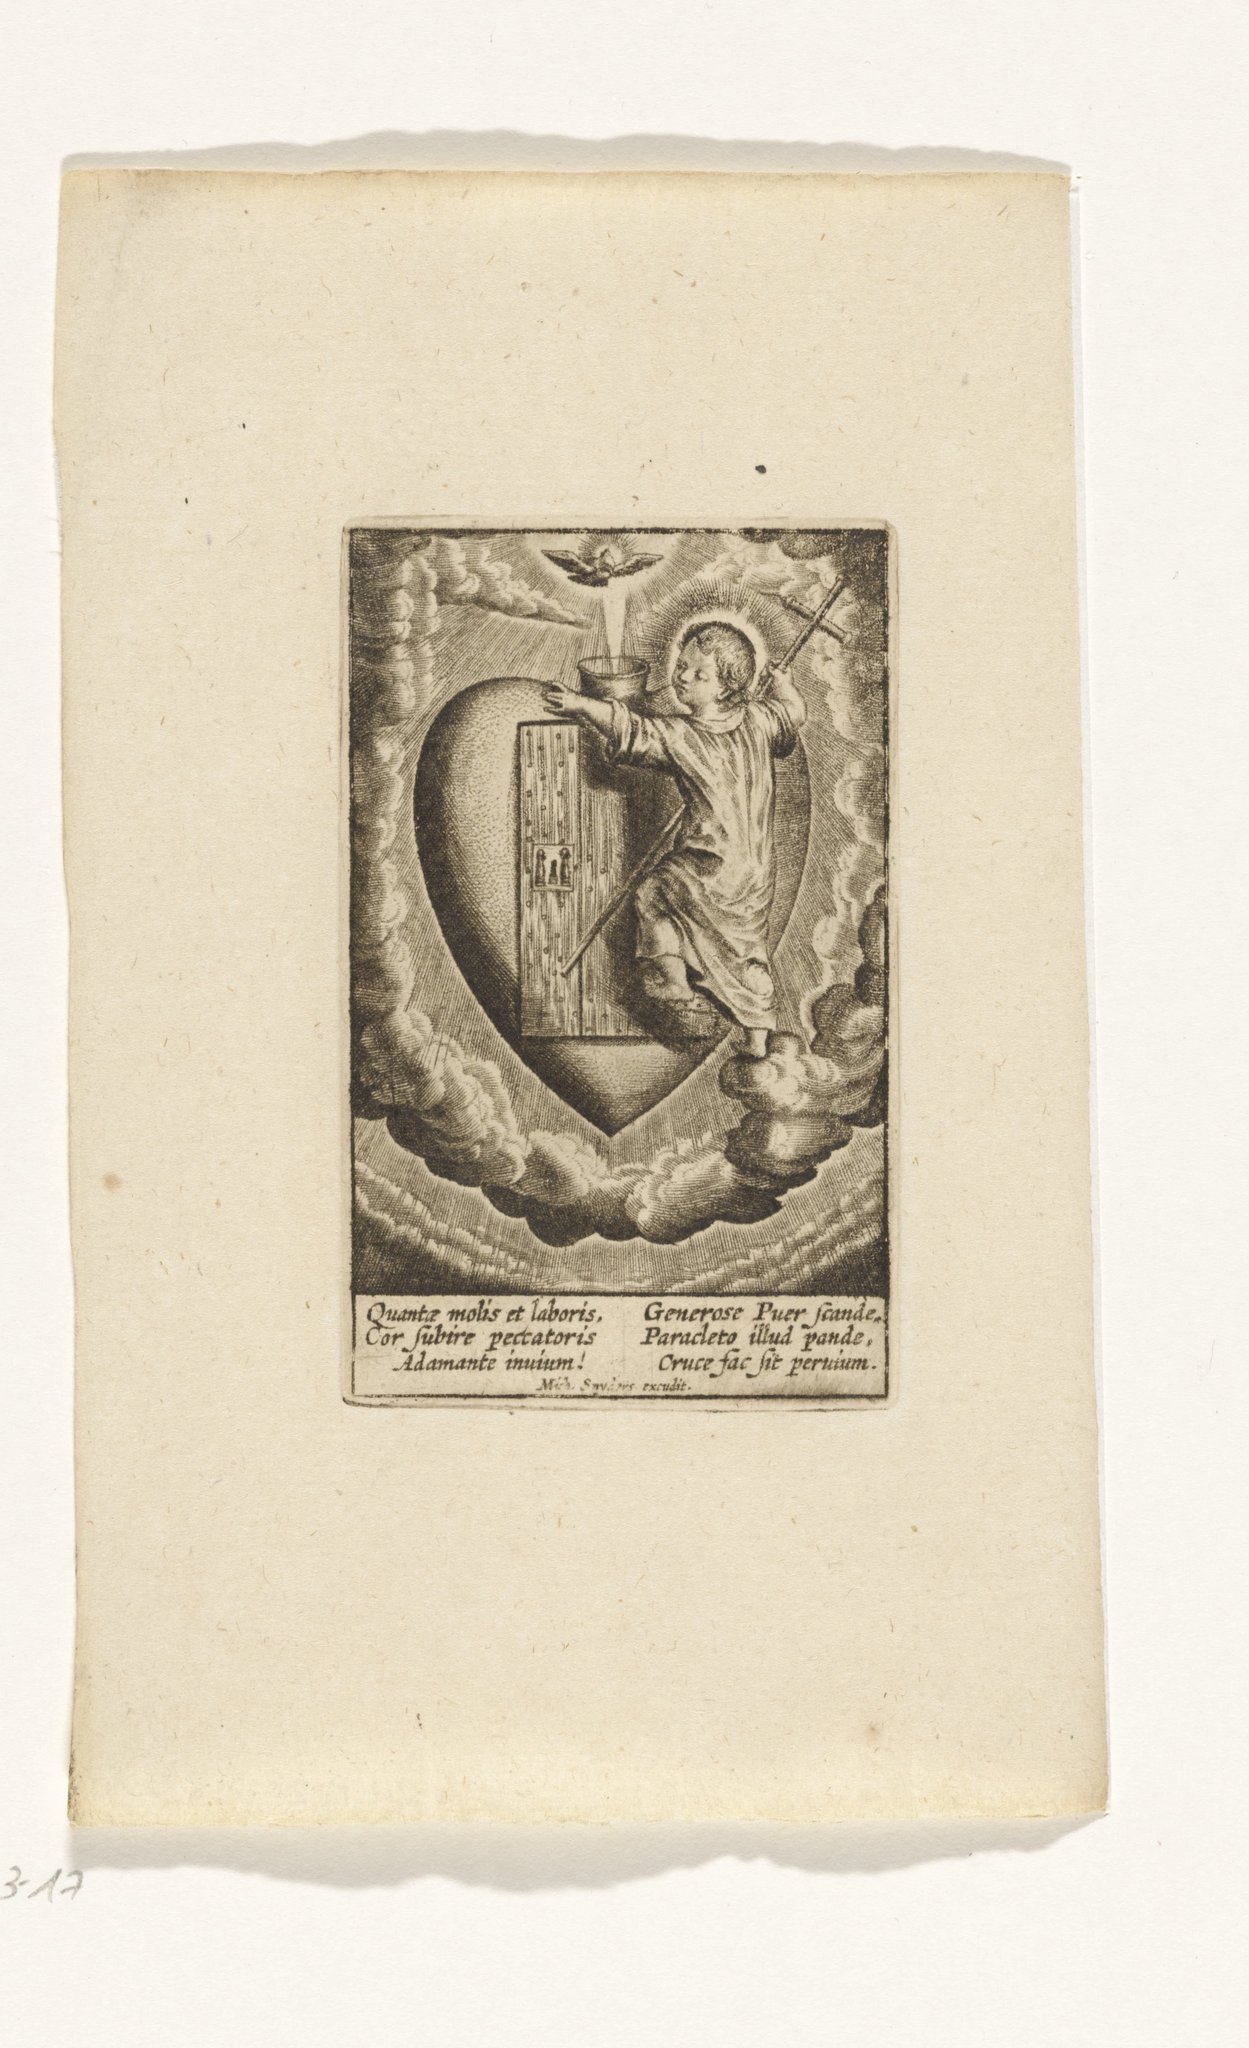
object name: print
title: Voor de deur van het heilige hart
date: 1630-1650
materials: paper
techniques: engraving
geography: antwerp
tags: the sacred heart, regular clerics, e.g. jesuits, redemptorists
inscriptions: collector's mark: Lugt 2228, collector's mark: Lugt 2760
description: Voor de deur van het heilige hart. Onderdeel van een serie van zeventien prenten over het menselijke hart overwonnen door het Christuskind, een thema gerelateerd aan de jezuïeten.